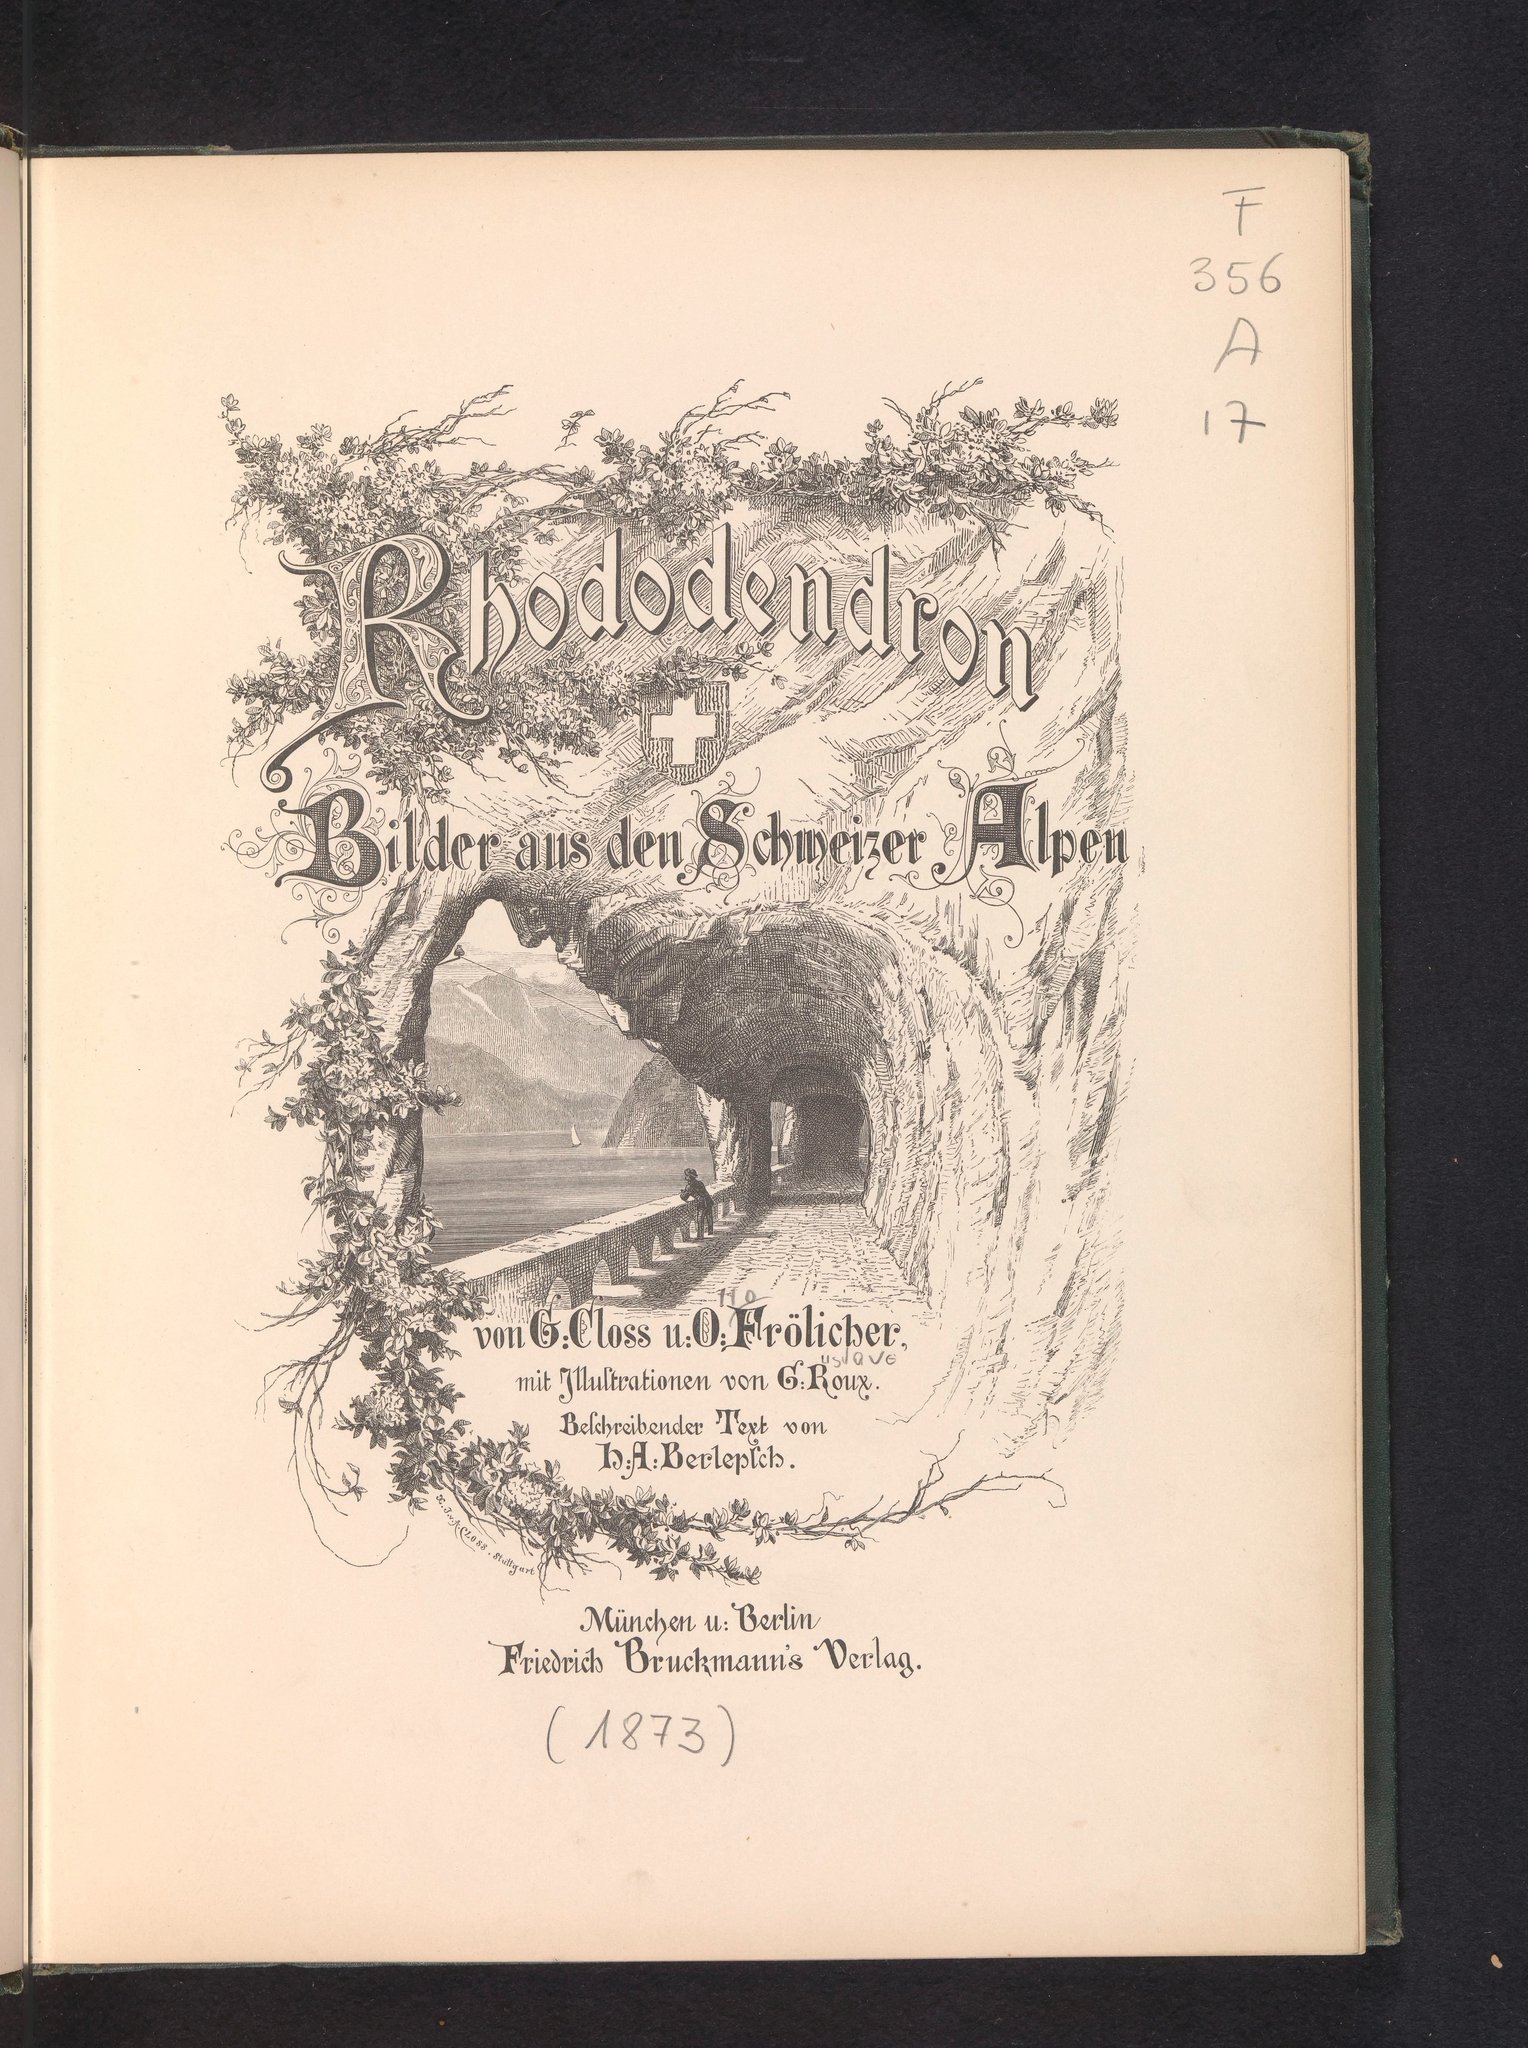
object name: book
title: Rhododendron Bilder aus den schweizer Alpen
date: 1873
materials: cardboard, linen, paper, photographic support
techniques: albumen print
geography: munich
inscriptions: name: ‘L. Hauser.’